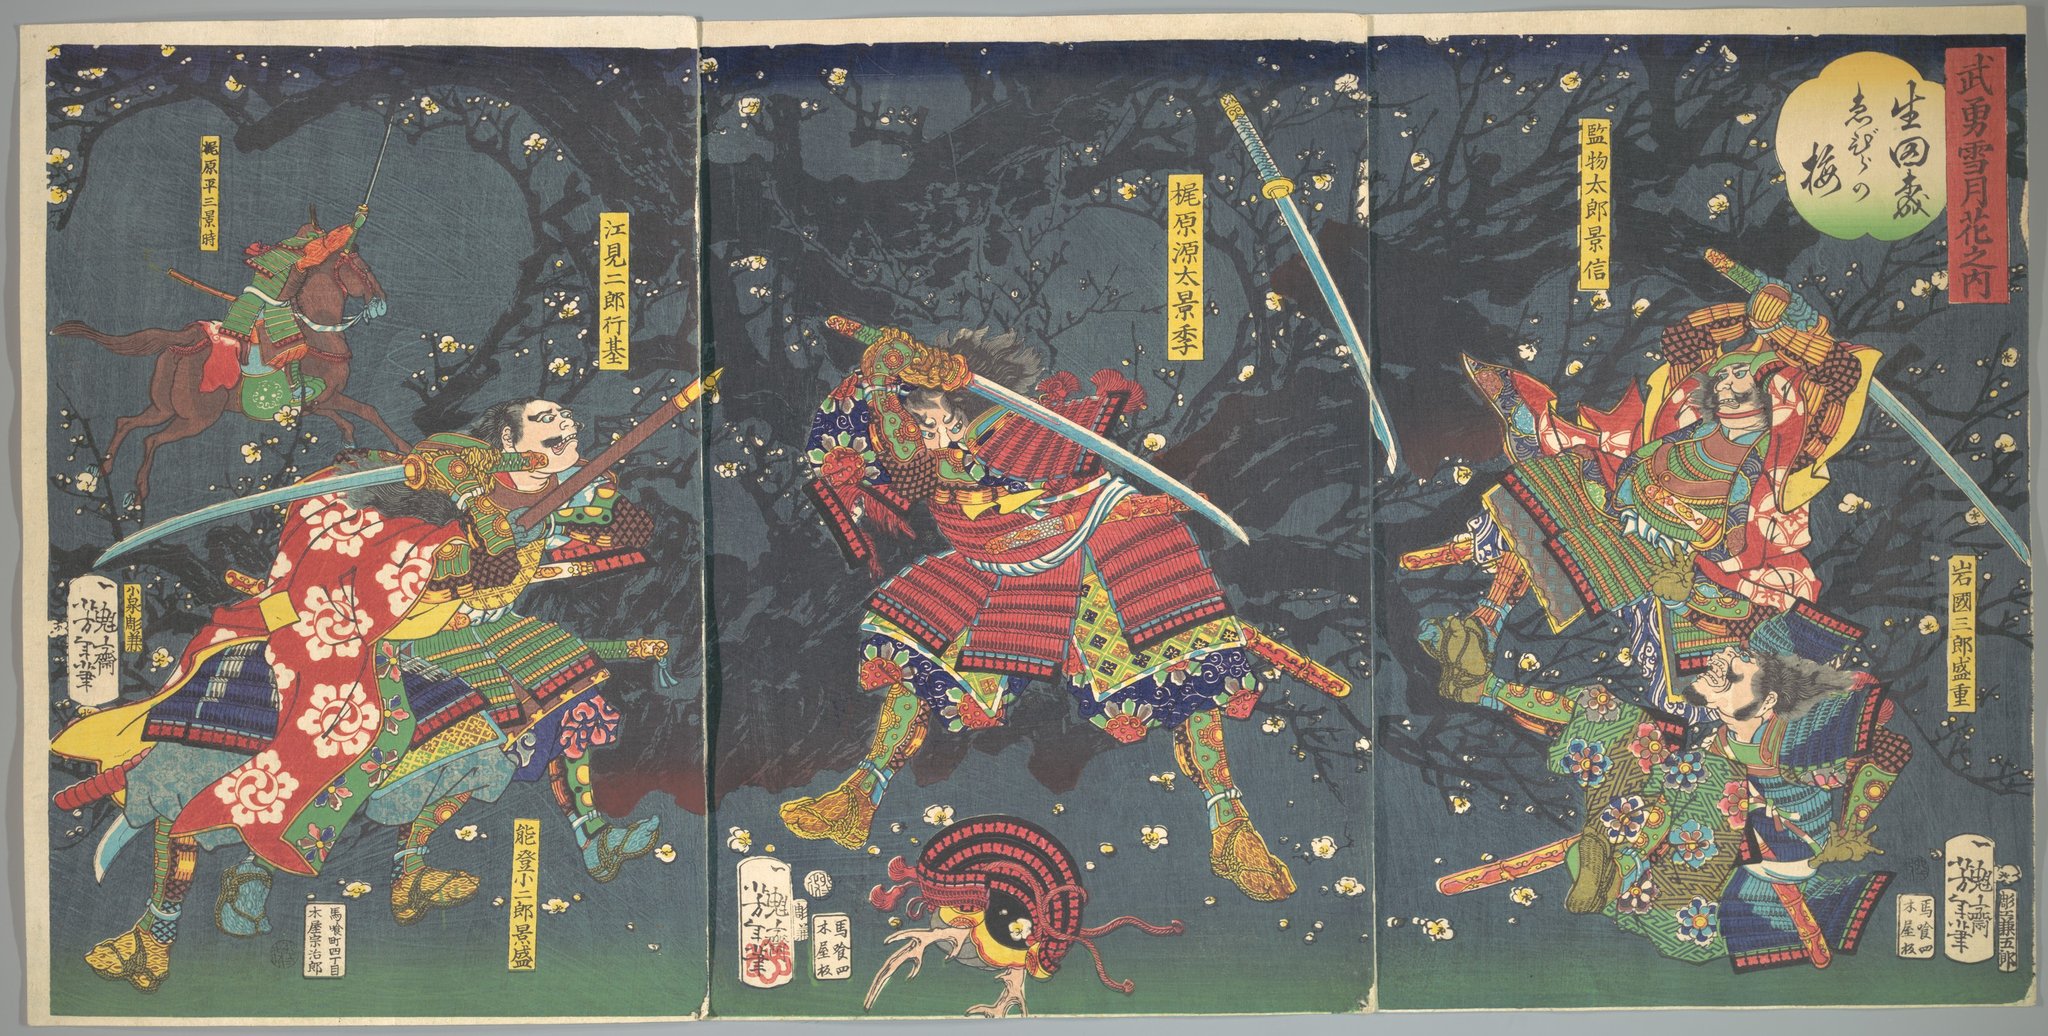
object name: print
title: Plum Blossoms in the Forrest of Ikuta, from the series Bravery-Beauty of the four seasons (Buyū setsugekka no uchi-Ikuta no mori, Ebira no ume)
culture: japanese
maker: tsukioka yoshitoshi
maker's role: artist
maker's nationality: japanese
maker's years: 1839-1892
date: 1867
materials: ink, paper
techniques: woodblock print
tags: battles,swords,men,horses